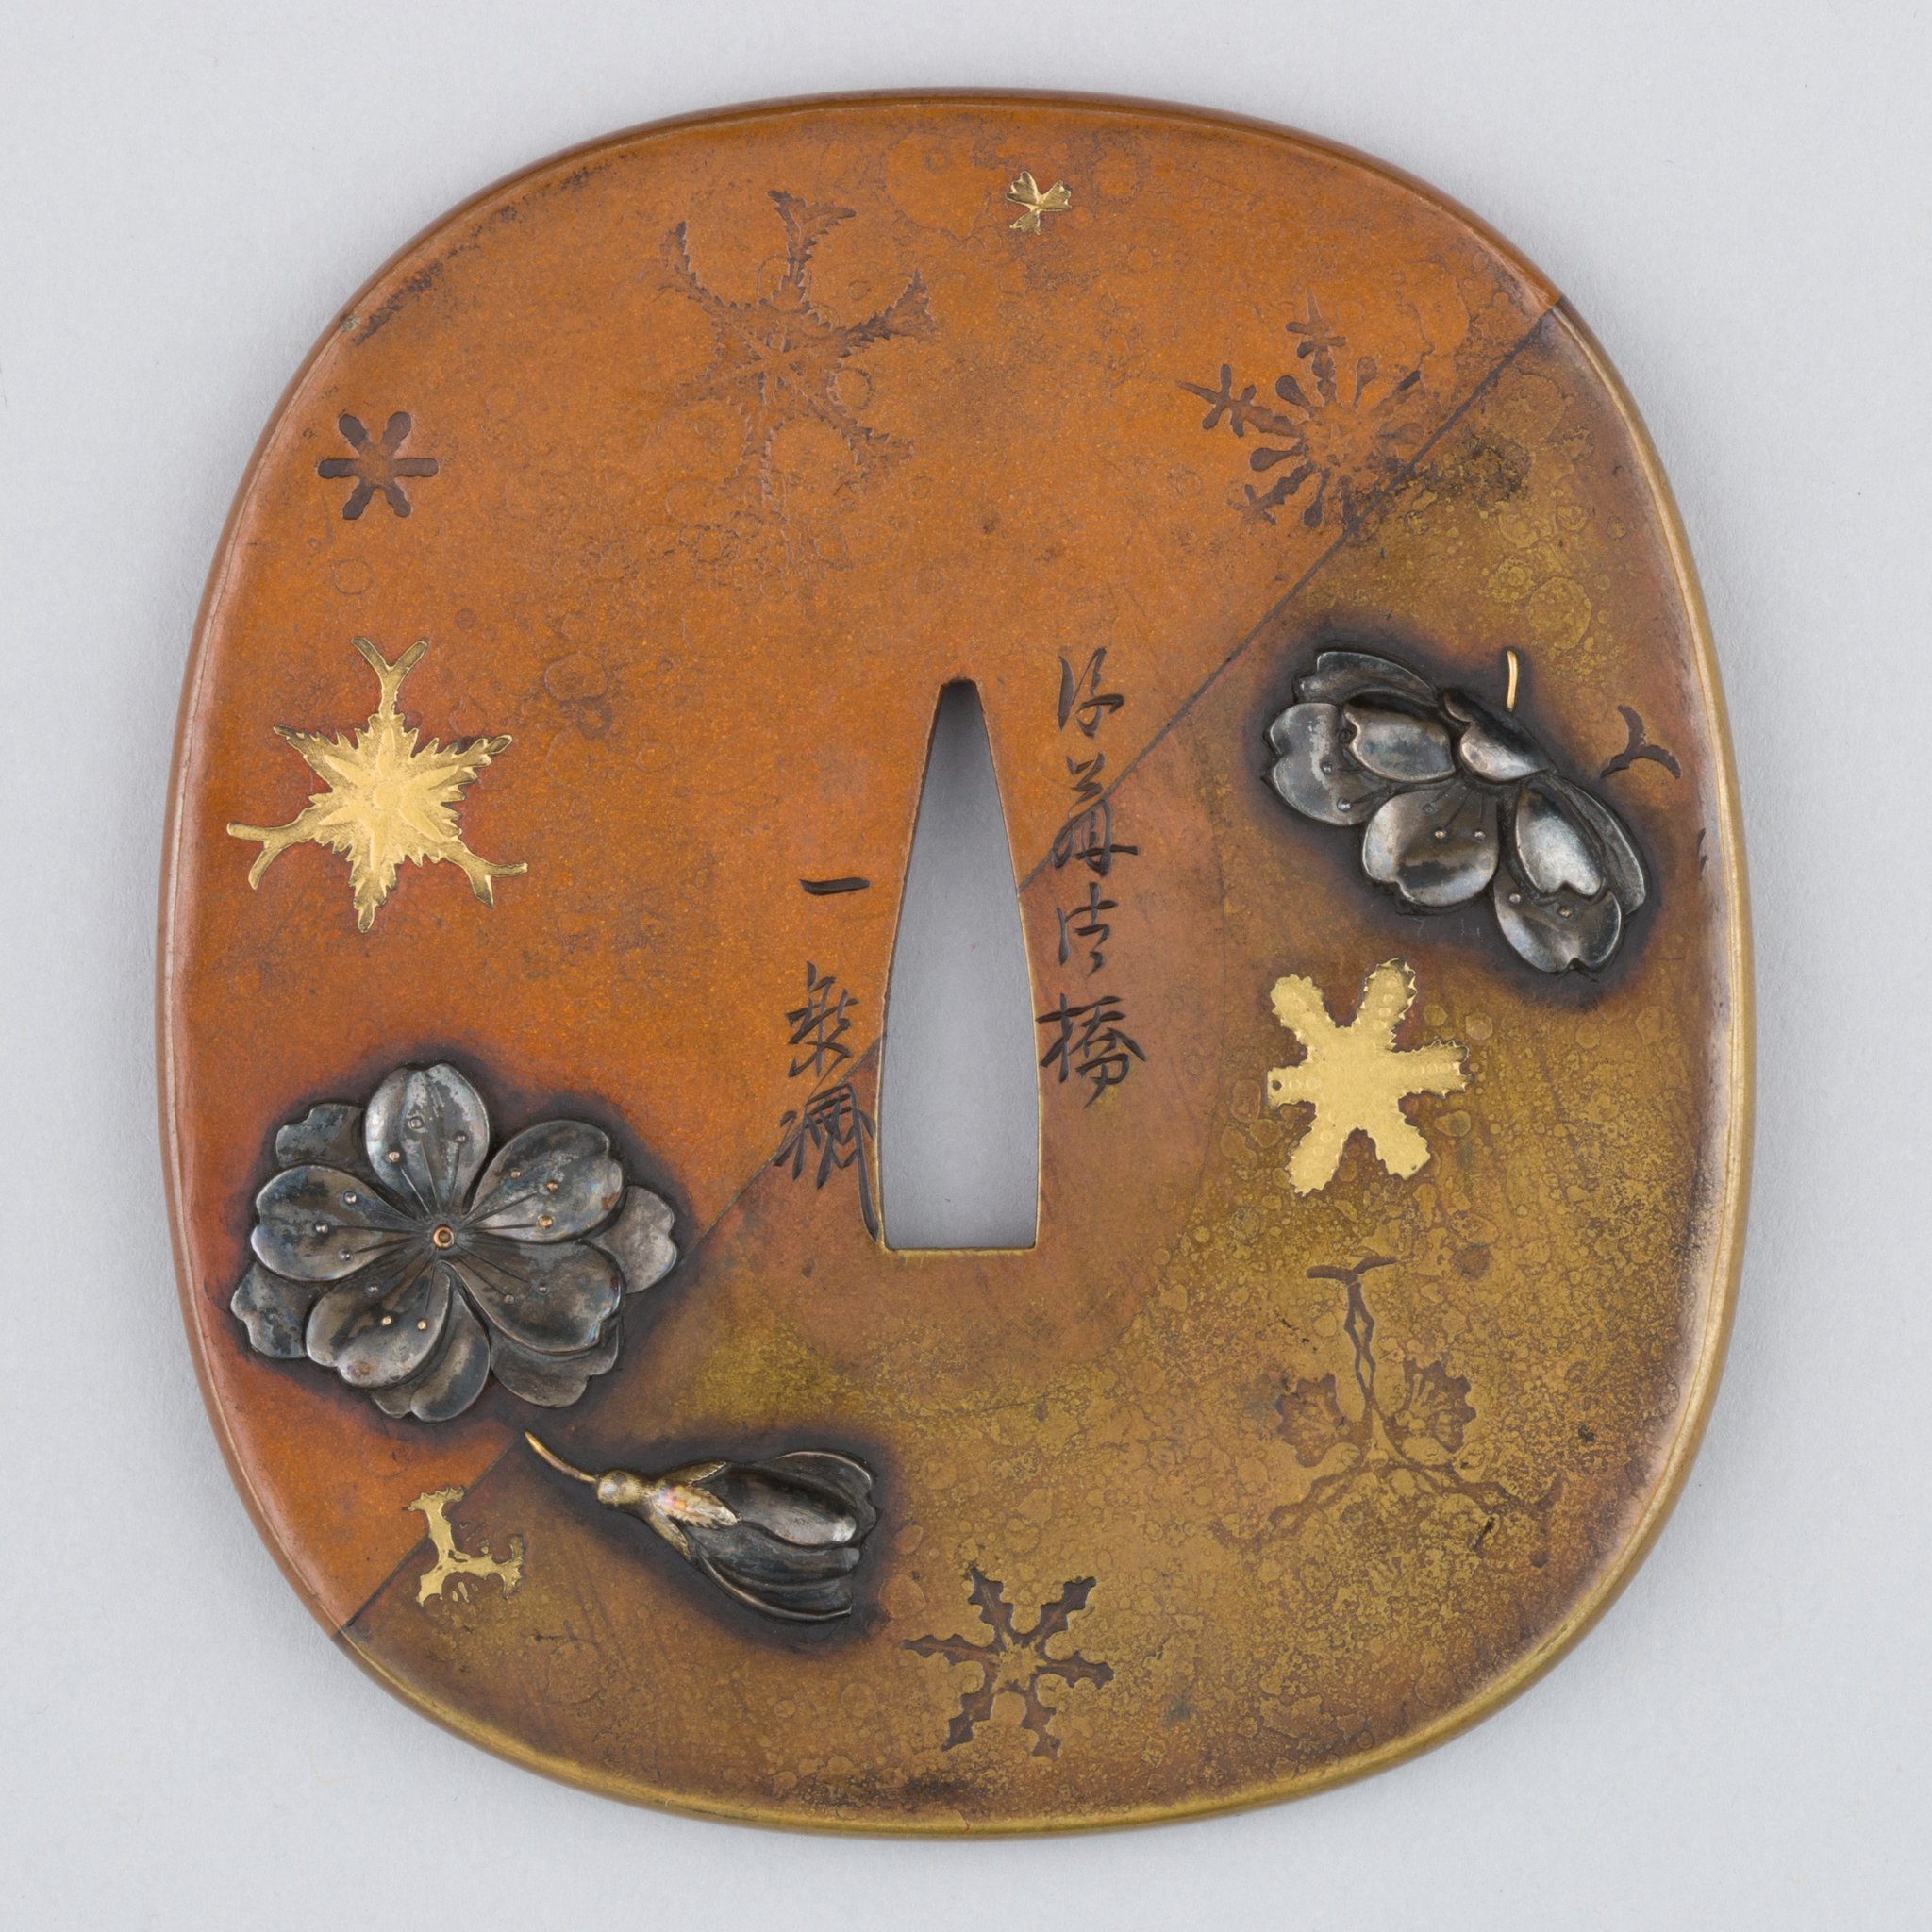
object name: sword guard tsuba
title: Sword Guard (Tsuba)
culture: japanese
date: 1801-1900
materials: copper, copper alloy, gold, silver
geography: japan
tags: flowers